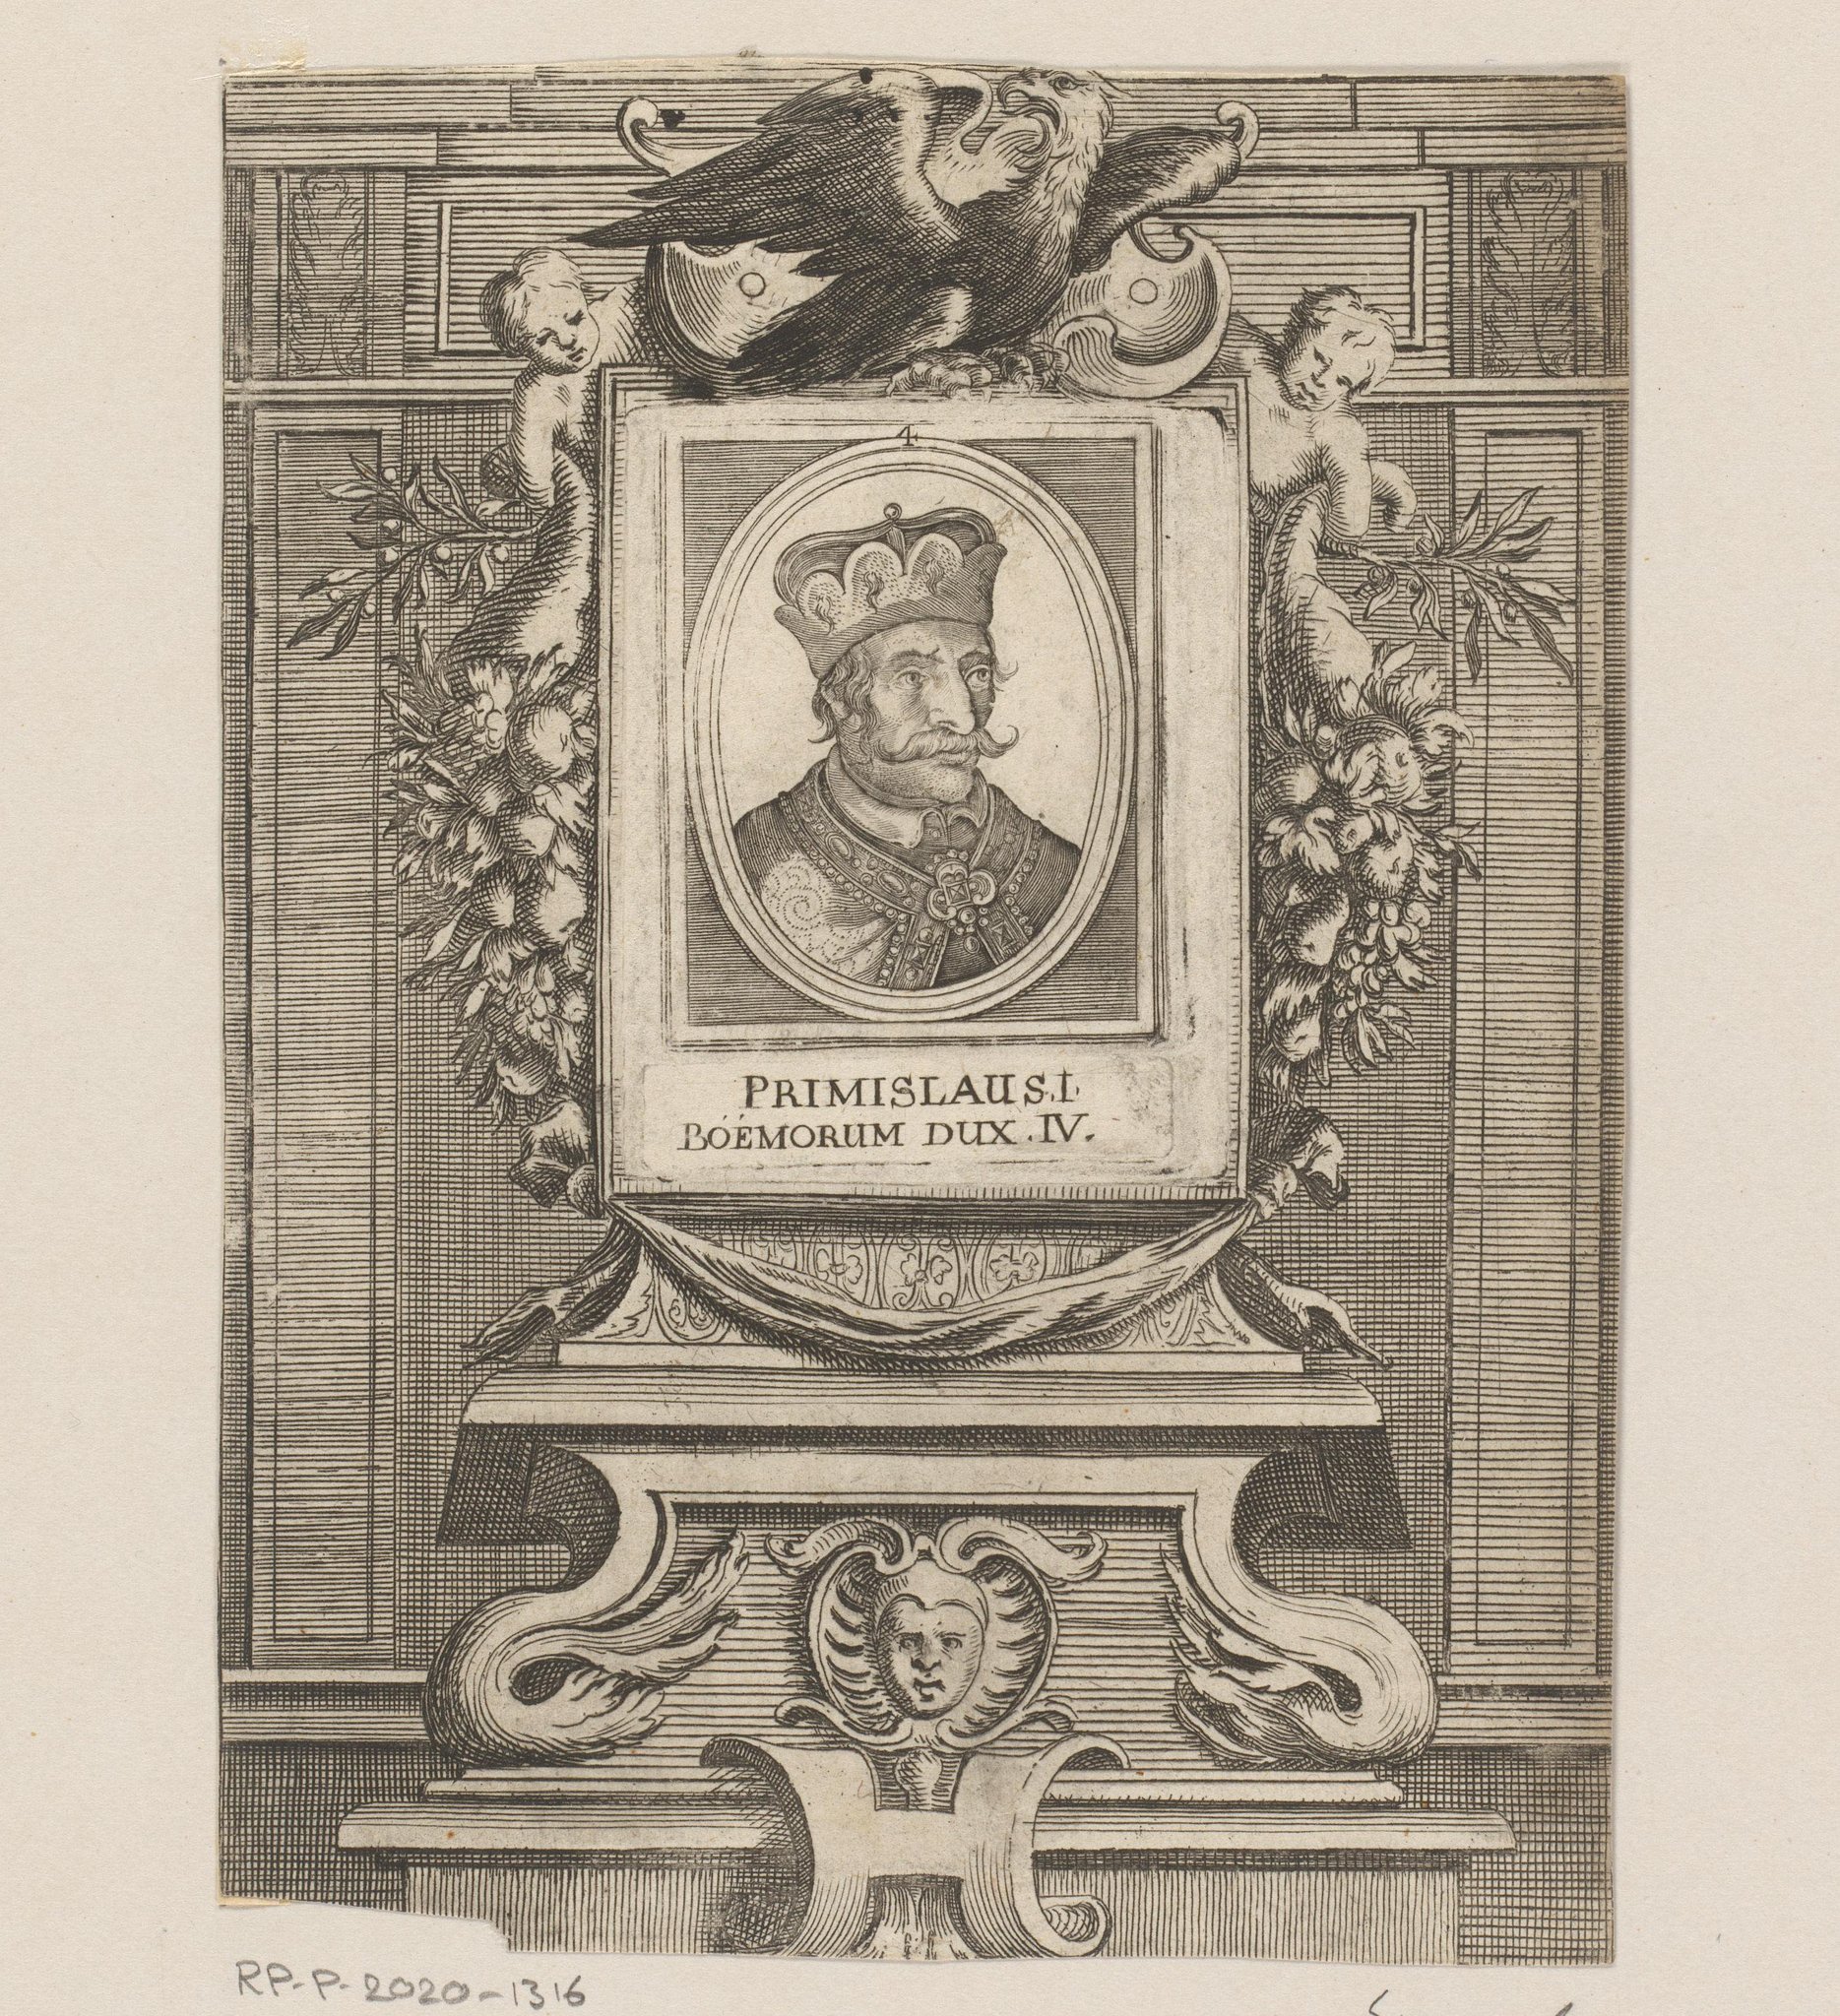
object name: print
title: Portret van Wenceleus I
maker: Anonymous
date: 1629-1673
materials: paper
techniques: engraving, etching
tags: historical persons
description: Portret zonder omlijsting ook gebruikt in: Althann, Michael Franz Ferdinand von. Elogia ducum regum intereggu qui boemis Praefverunt. Praag: Pauli Sessi, 1629. Portret met andere omlijsting gebruikt in: Althann, Michael Franz Ferdinand von. Tibi Ferdinande III Reie optime boemorum (...). Praag: s.n., 1673.